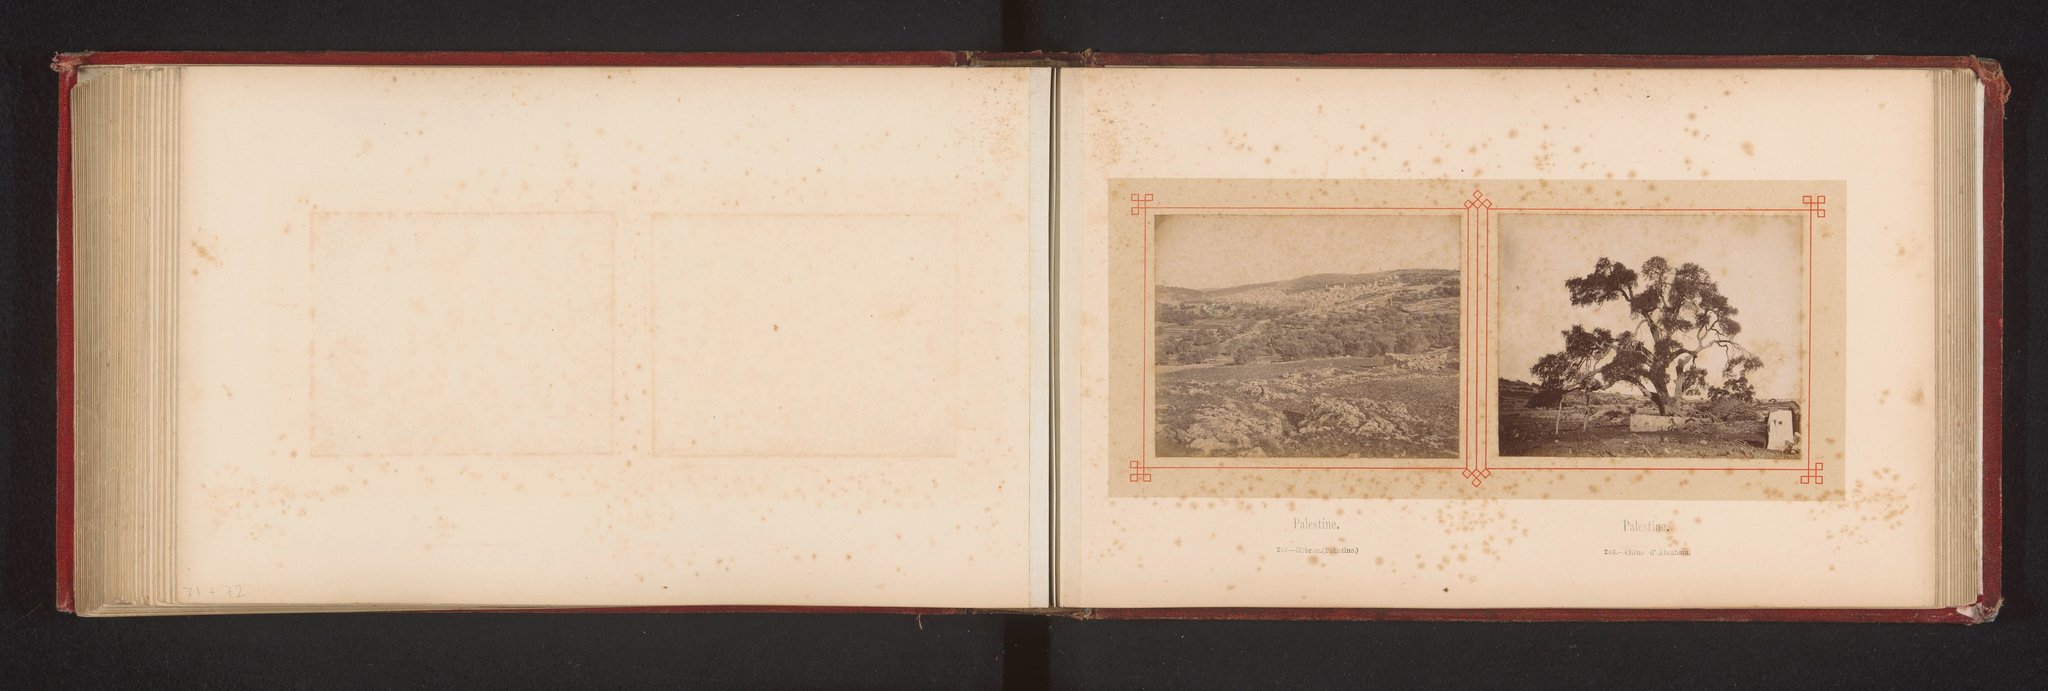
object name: page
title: Palestine - 243.- Hébron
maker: félix bonfils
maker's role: fotograaf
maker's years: 1831-1885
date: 1873-1878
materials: photographic support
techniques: albumen print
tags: city-view, and landscape with man-made constructions